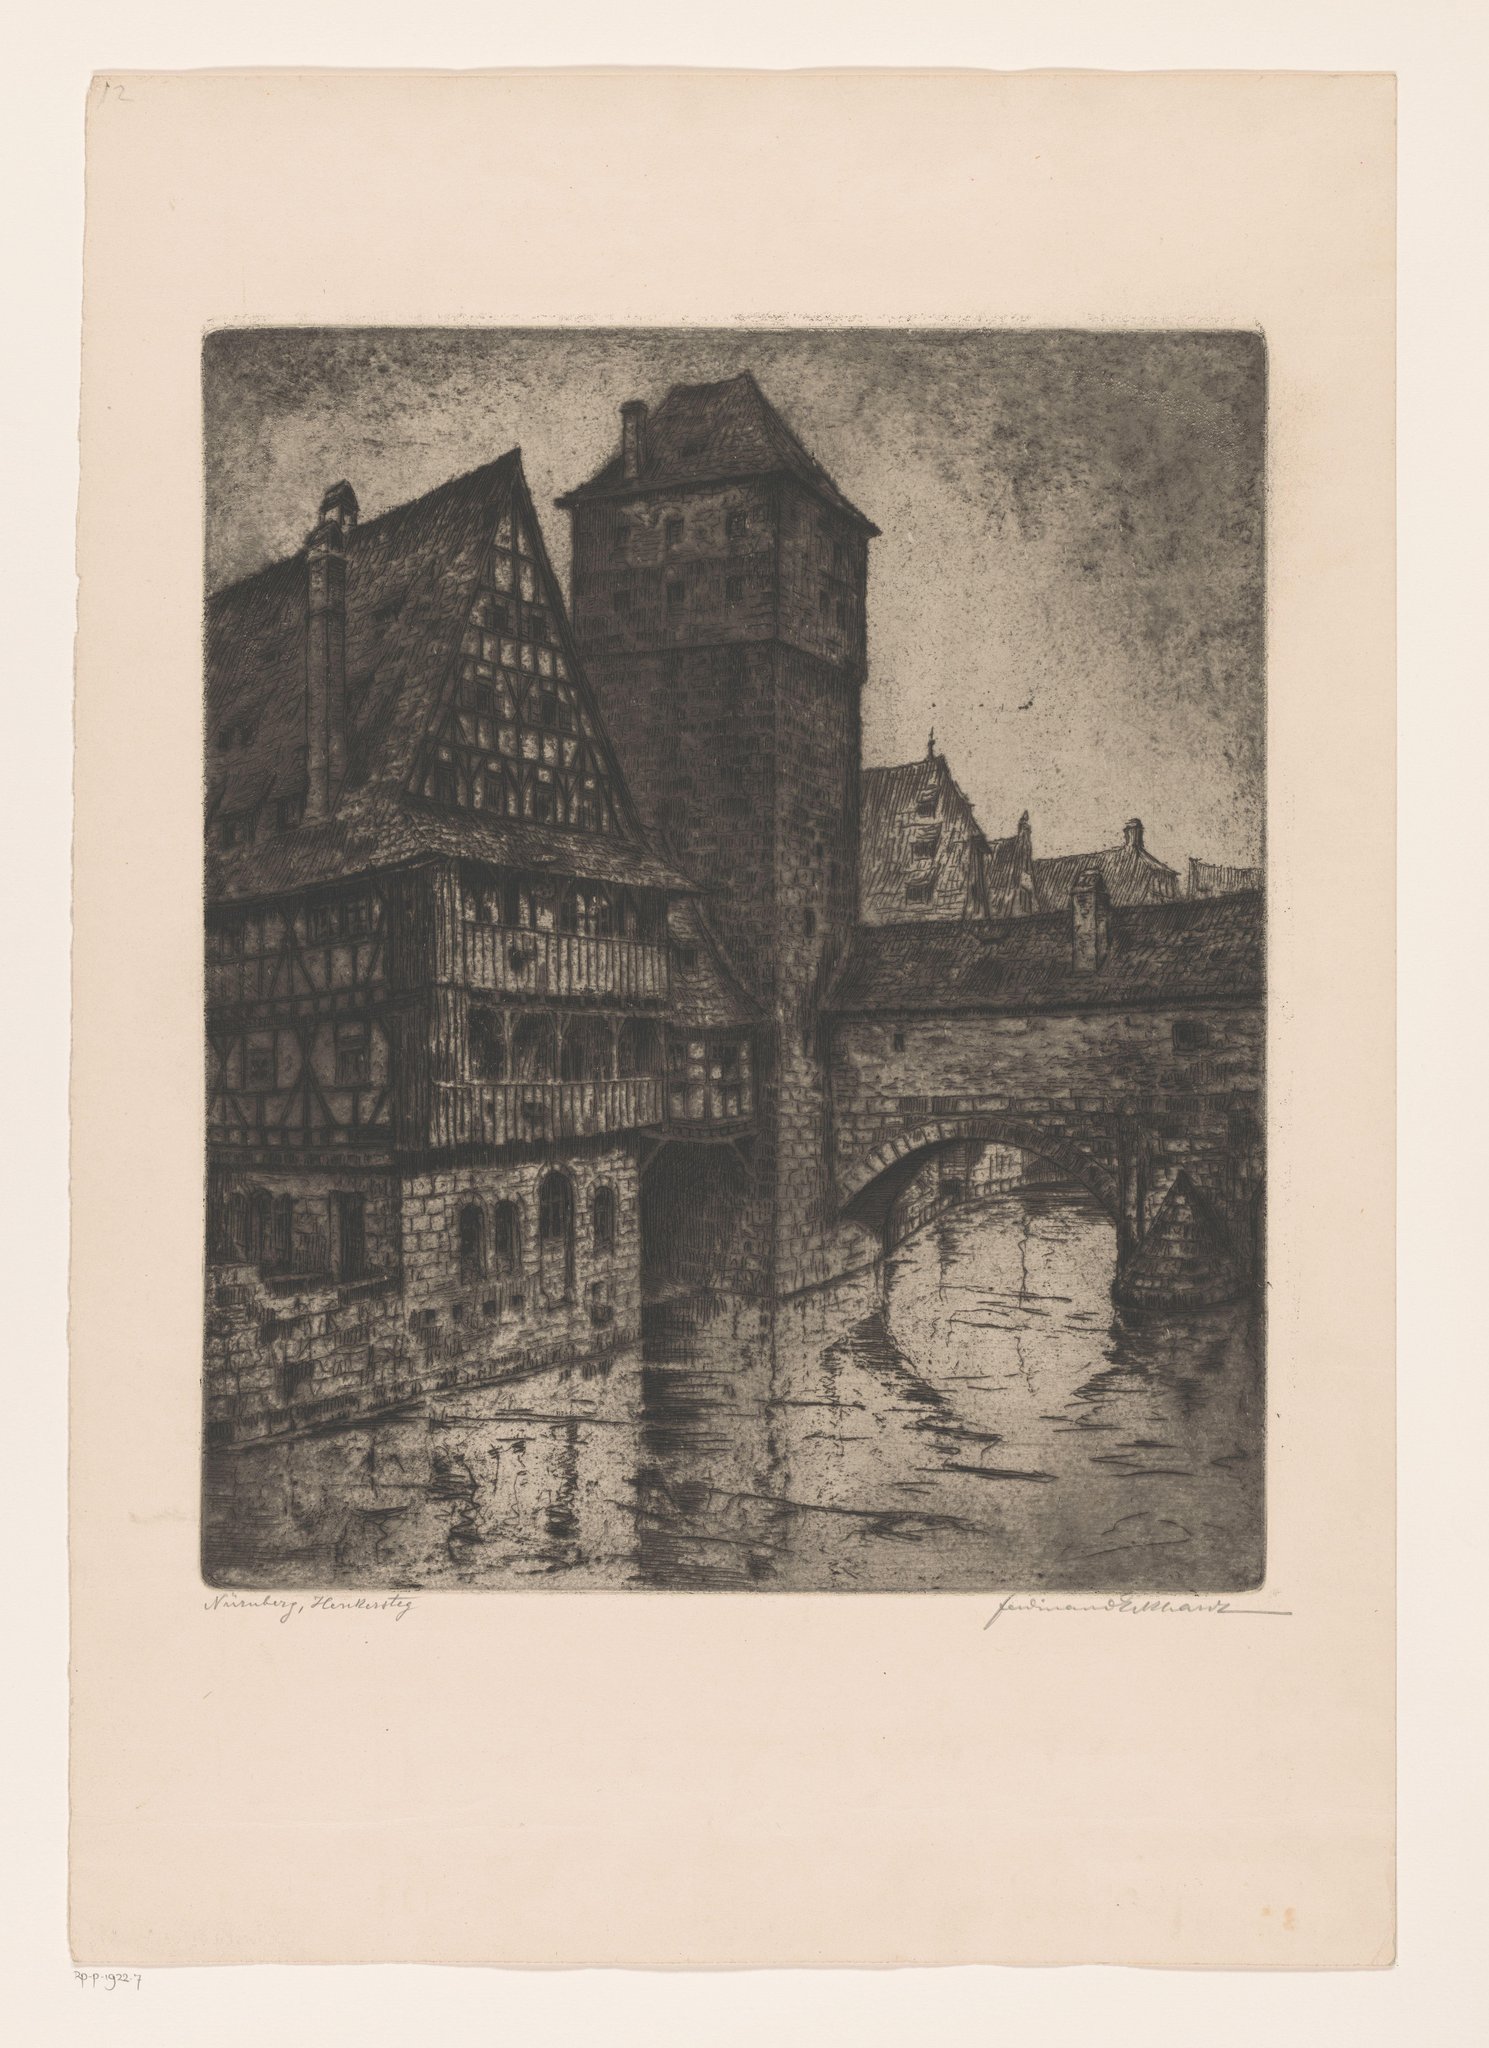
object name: print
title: Nürnberg, Henkersteg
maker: ferdinand eckhardt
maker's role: print maker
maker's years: 1876-1952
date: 1886-1922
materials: paper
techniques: drypoint, etching, intaglio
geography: austria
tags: urban housing, bridge with structure, i.e. cover or buildings, bridge in city across river, canal, etc.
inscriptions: collector's mark: Lugt 2228